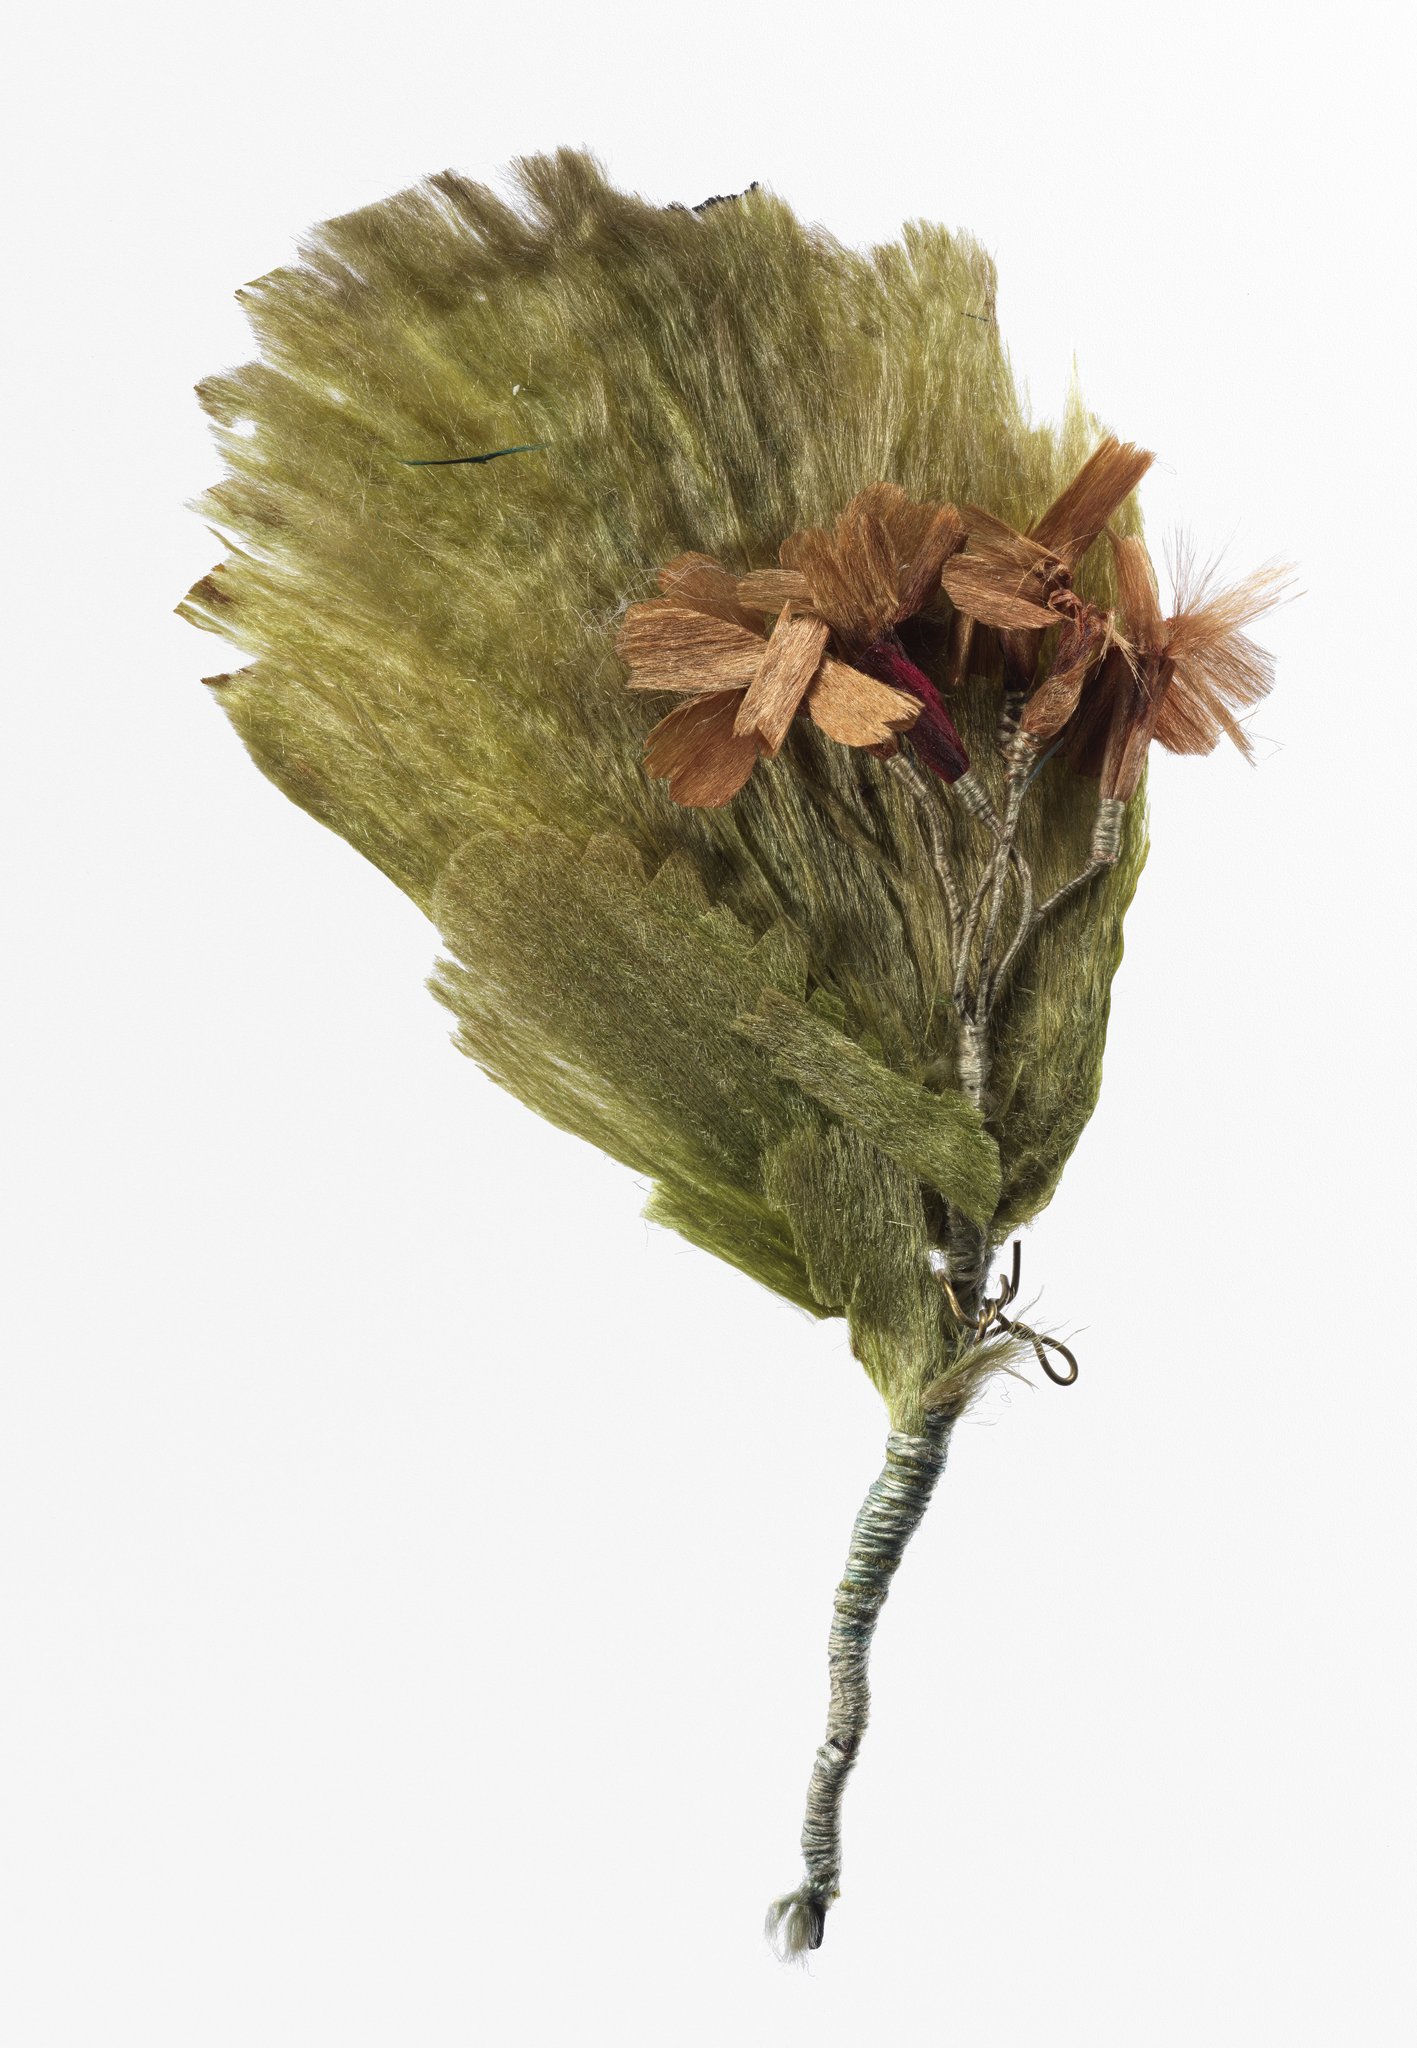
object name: boutonnière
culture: british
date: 1625-1649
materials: silk